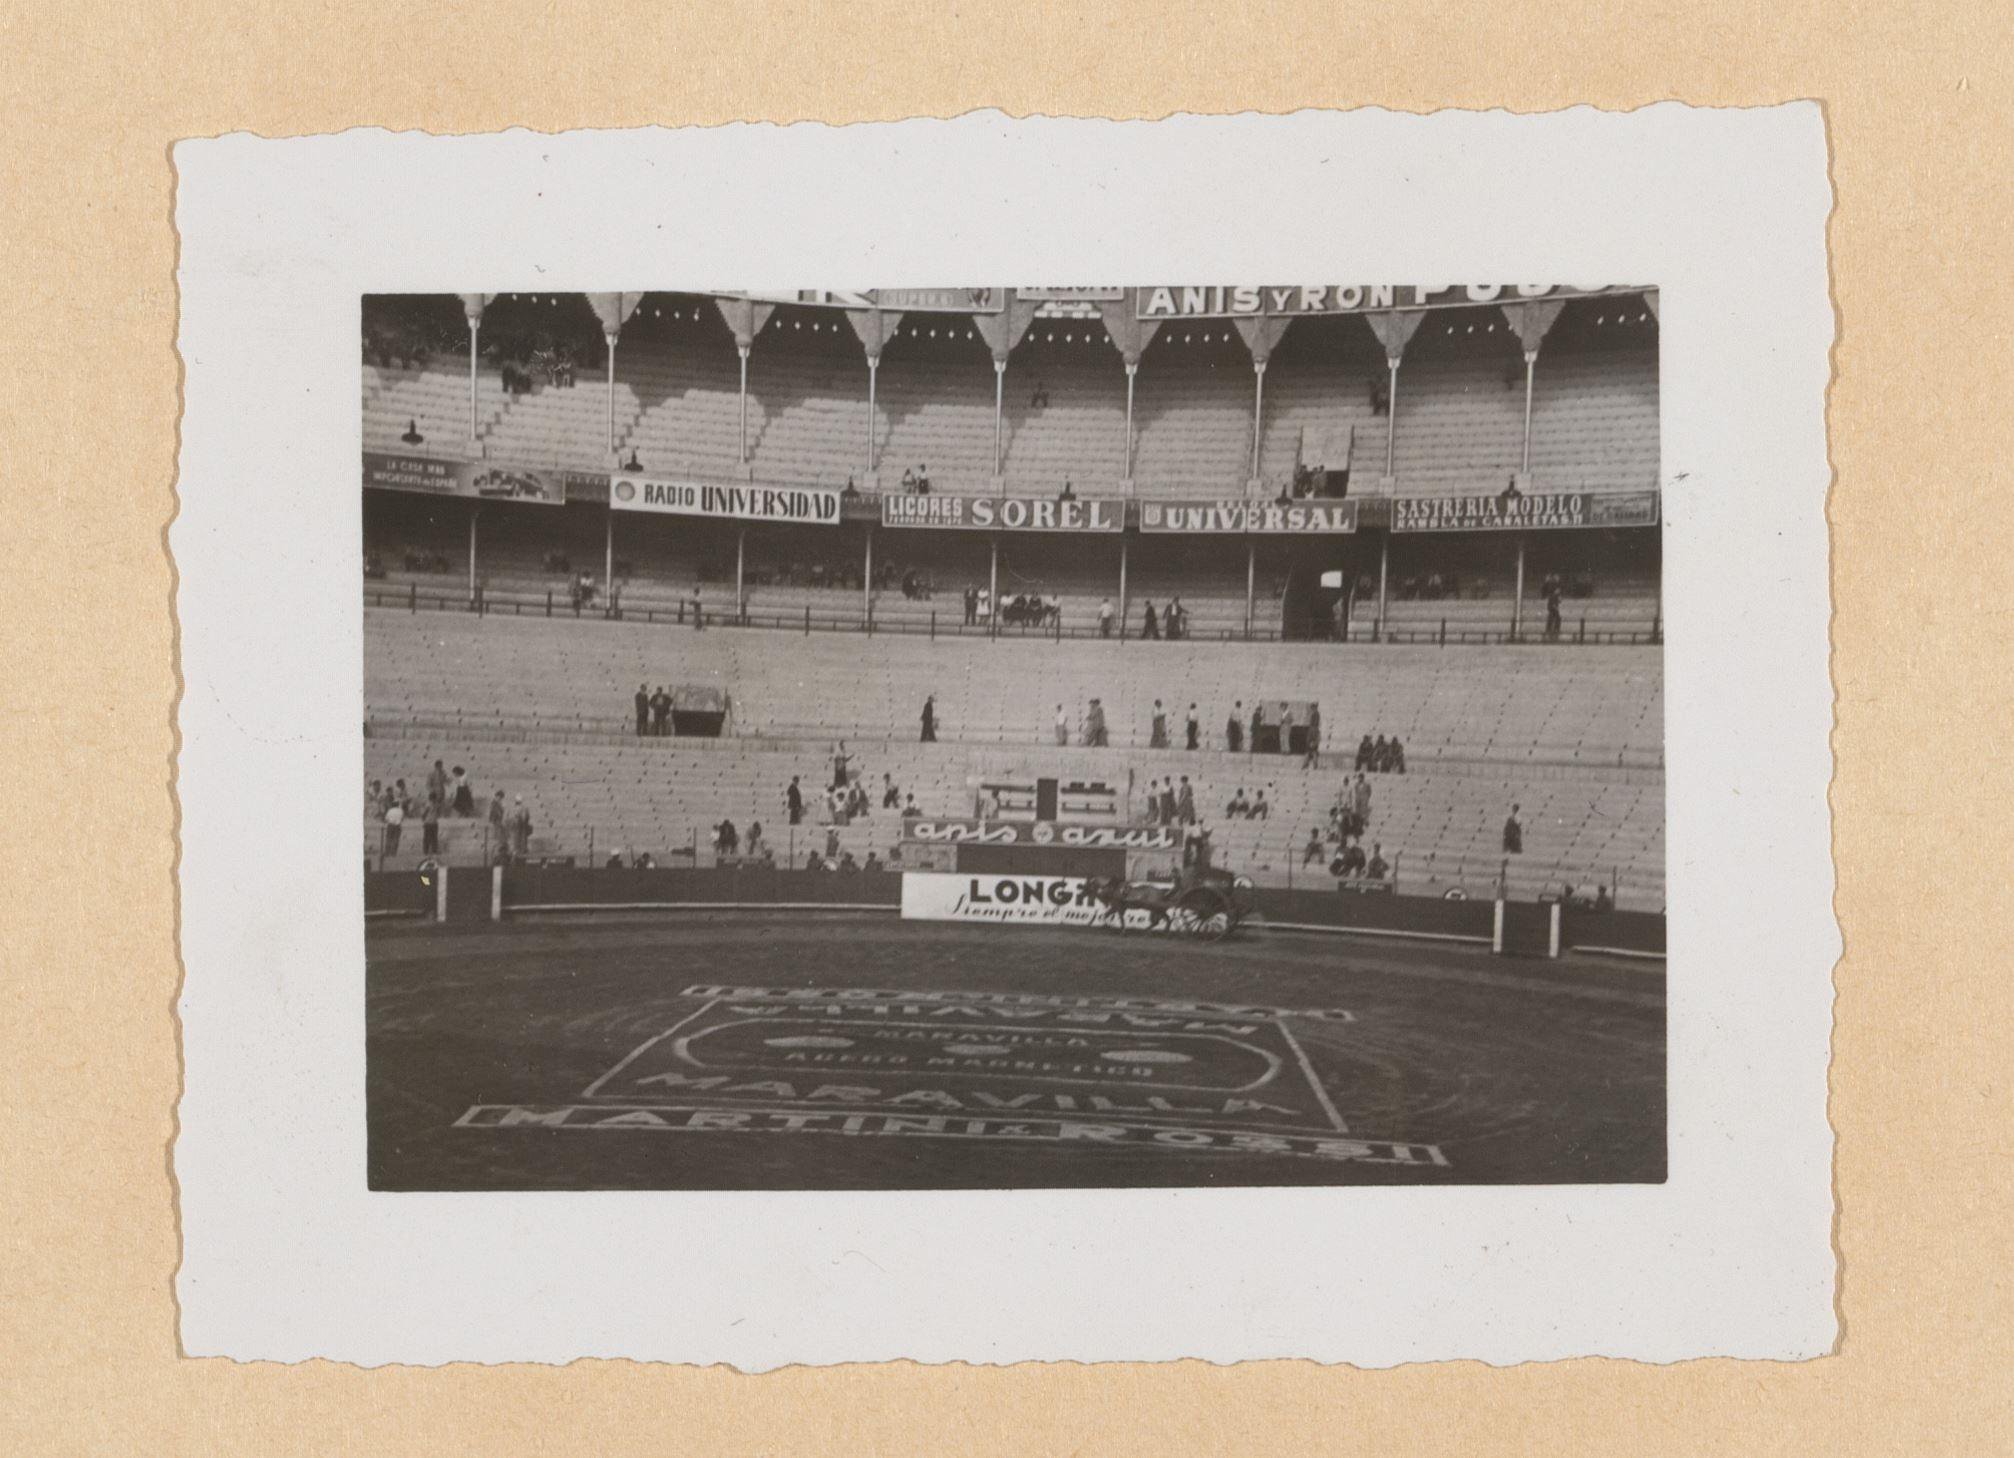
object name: album leaf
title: Arena na het stierengevecht, Barcelona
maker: Anonymous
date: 1955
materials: paper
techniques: gelatin silver print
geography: barcelona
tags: grounds, fields and accomodations for sports, games and physical performances